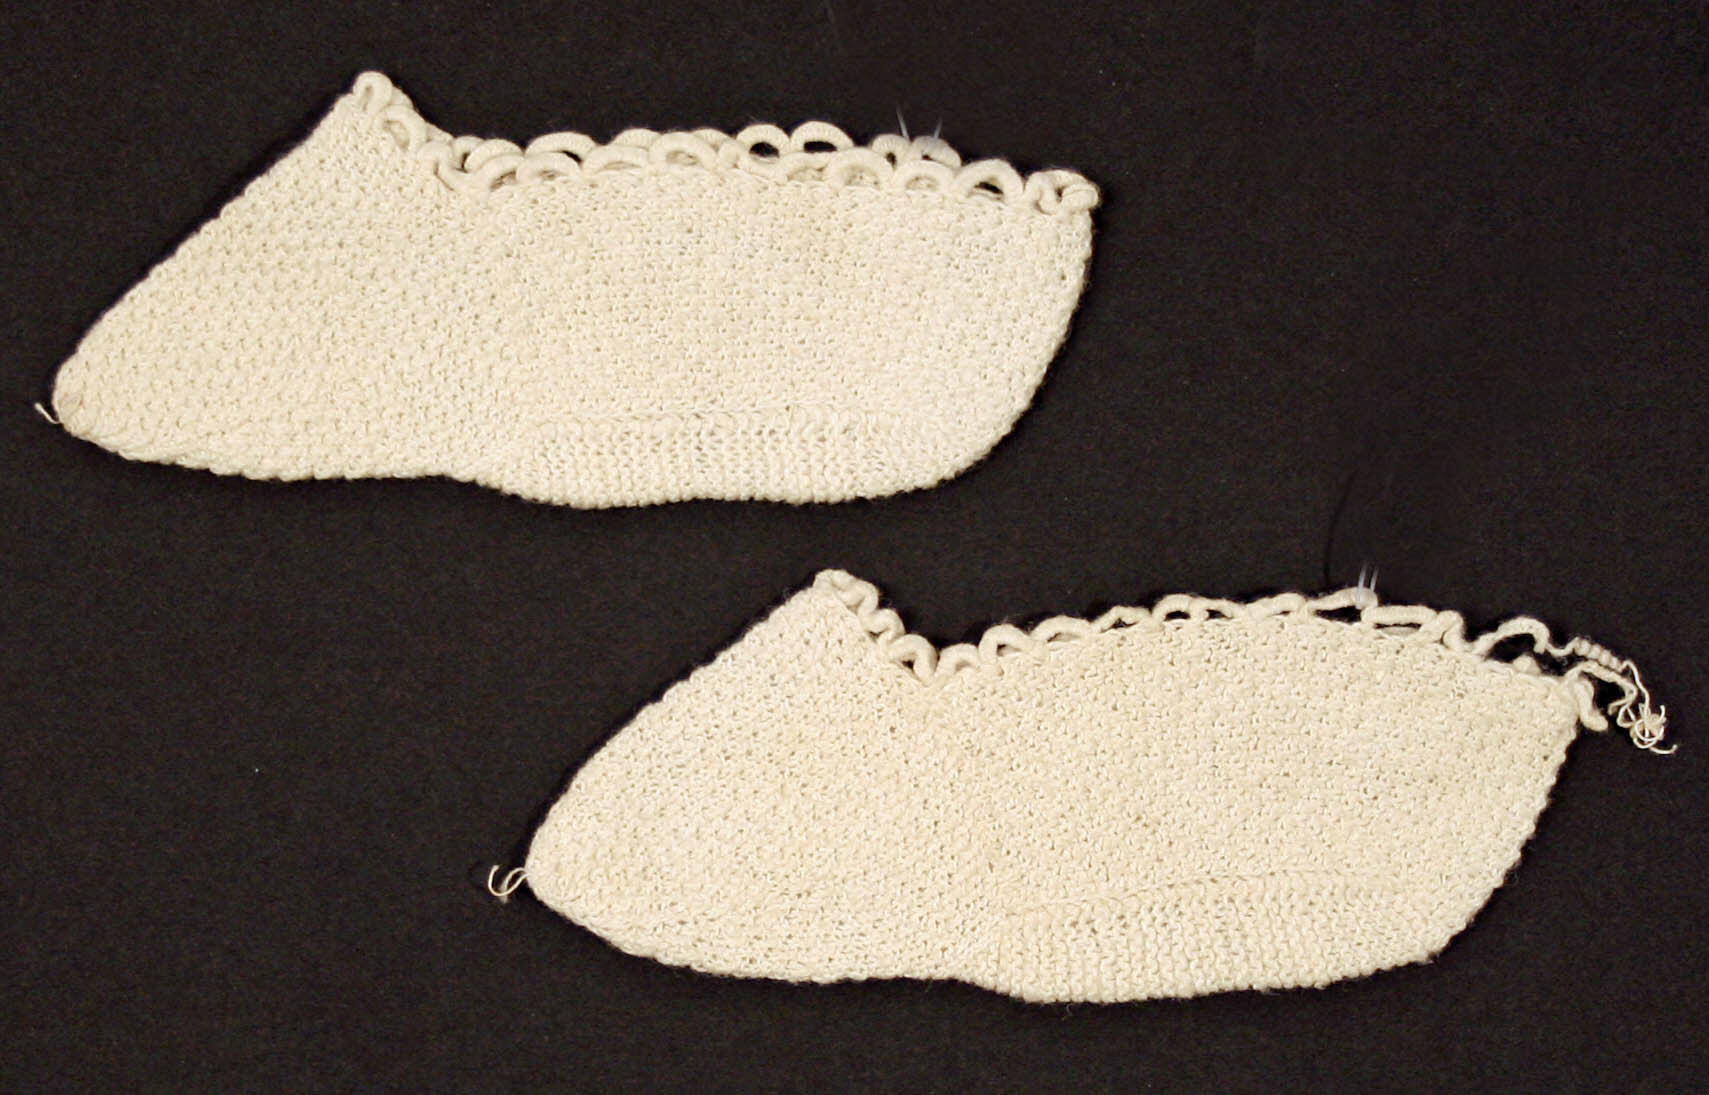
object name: sock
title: Socks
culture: german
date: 1780